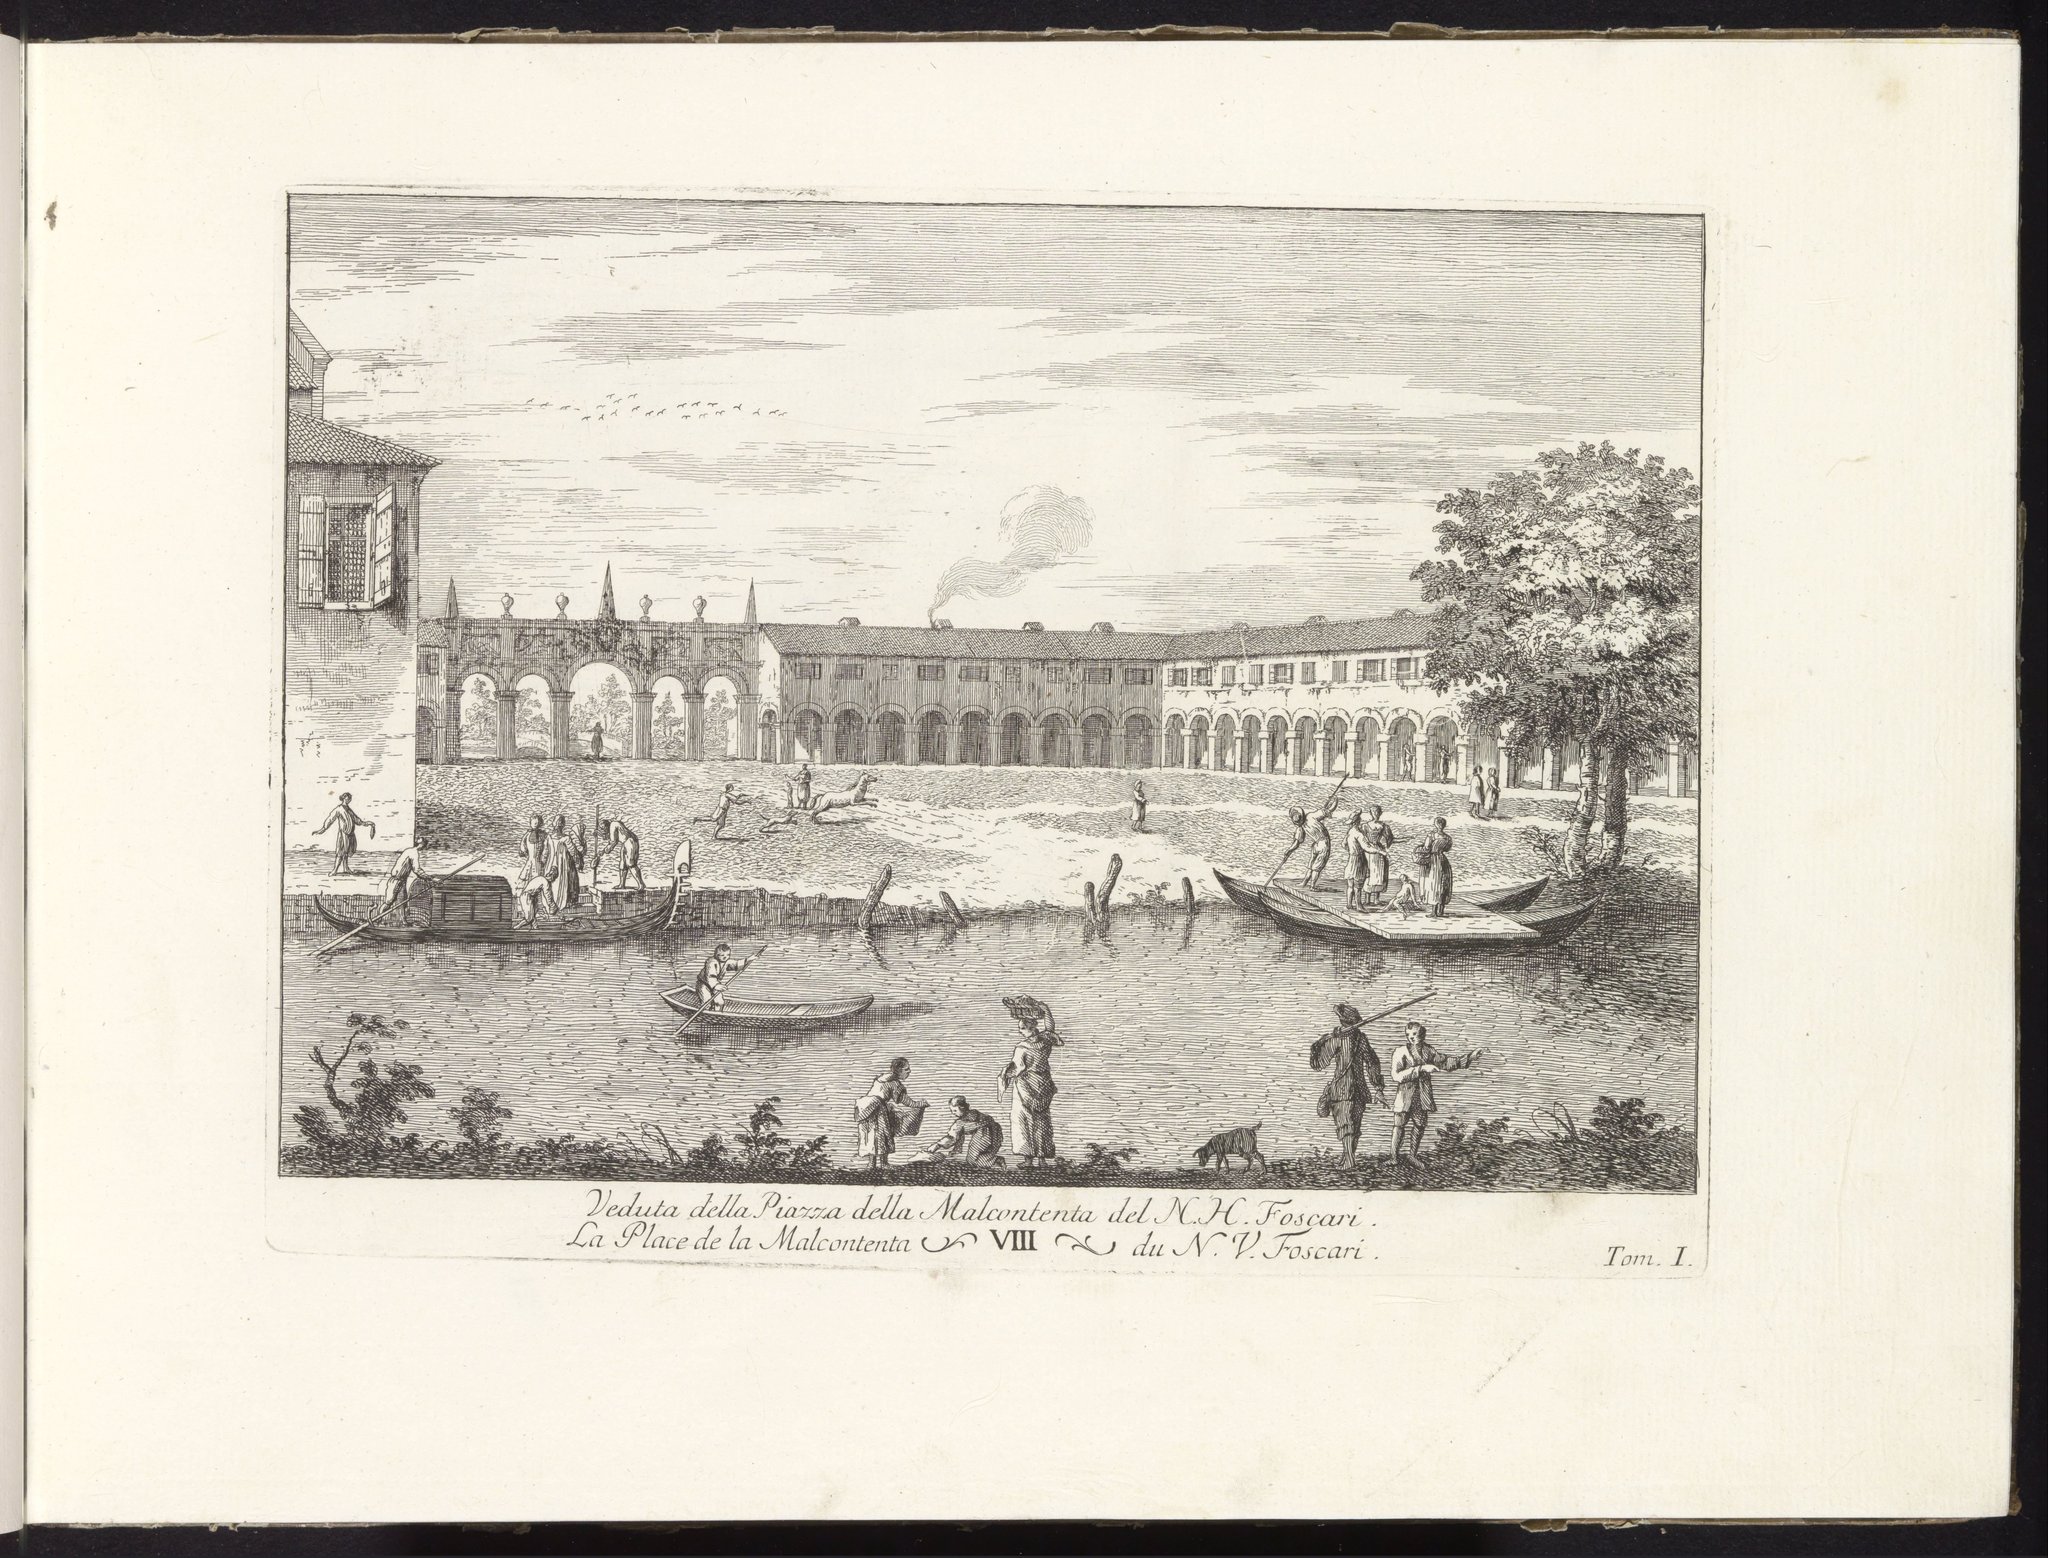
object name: print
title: Vedute della Piazza della Malcontenta del N. H. Foscar (...)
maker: giovanni francesco costa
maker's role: draughtsman, painter, print maker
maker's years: -1773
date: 1750-1760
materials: paper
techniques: etching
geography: venice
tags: square, place, circus, etc., river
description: Gezicht op Piazza della Malcontenta del N. H. Foscari aan de rivier de Brenta. Genummerd midden onder: VIII en rechtsonder: Tom: I. Deze prent maakt deel uit van een album.